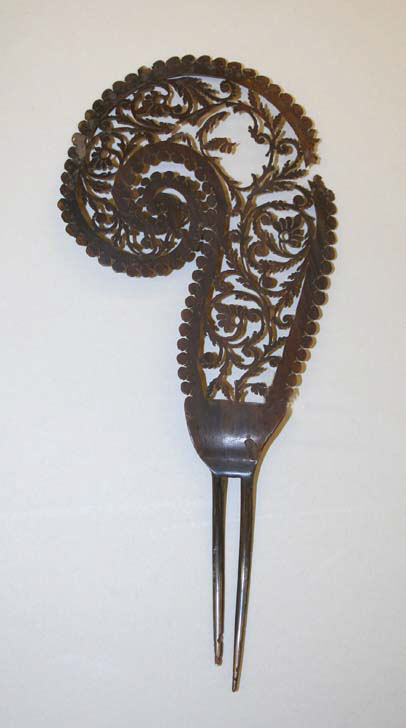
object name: comb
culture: german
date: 1801-1900